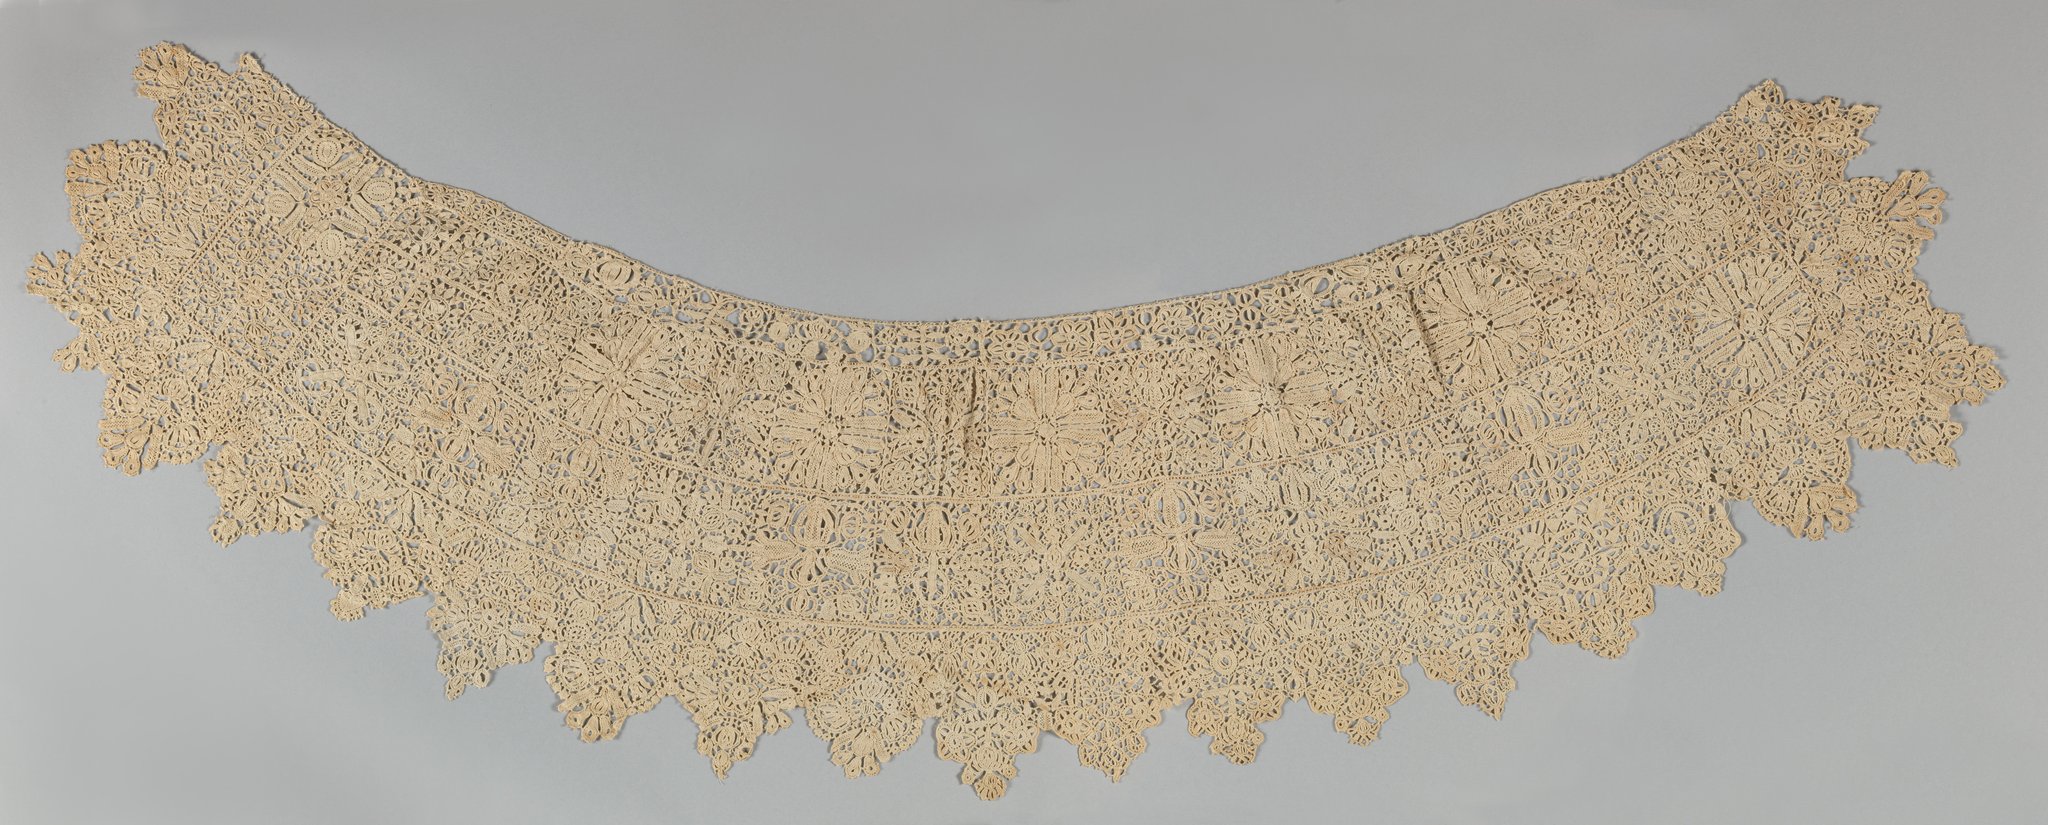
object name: collar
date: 1630-1639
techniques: lace